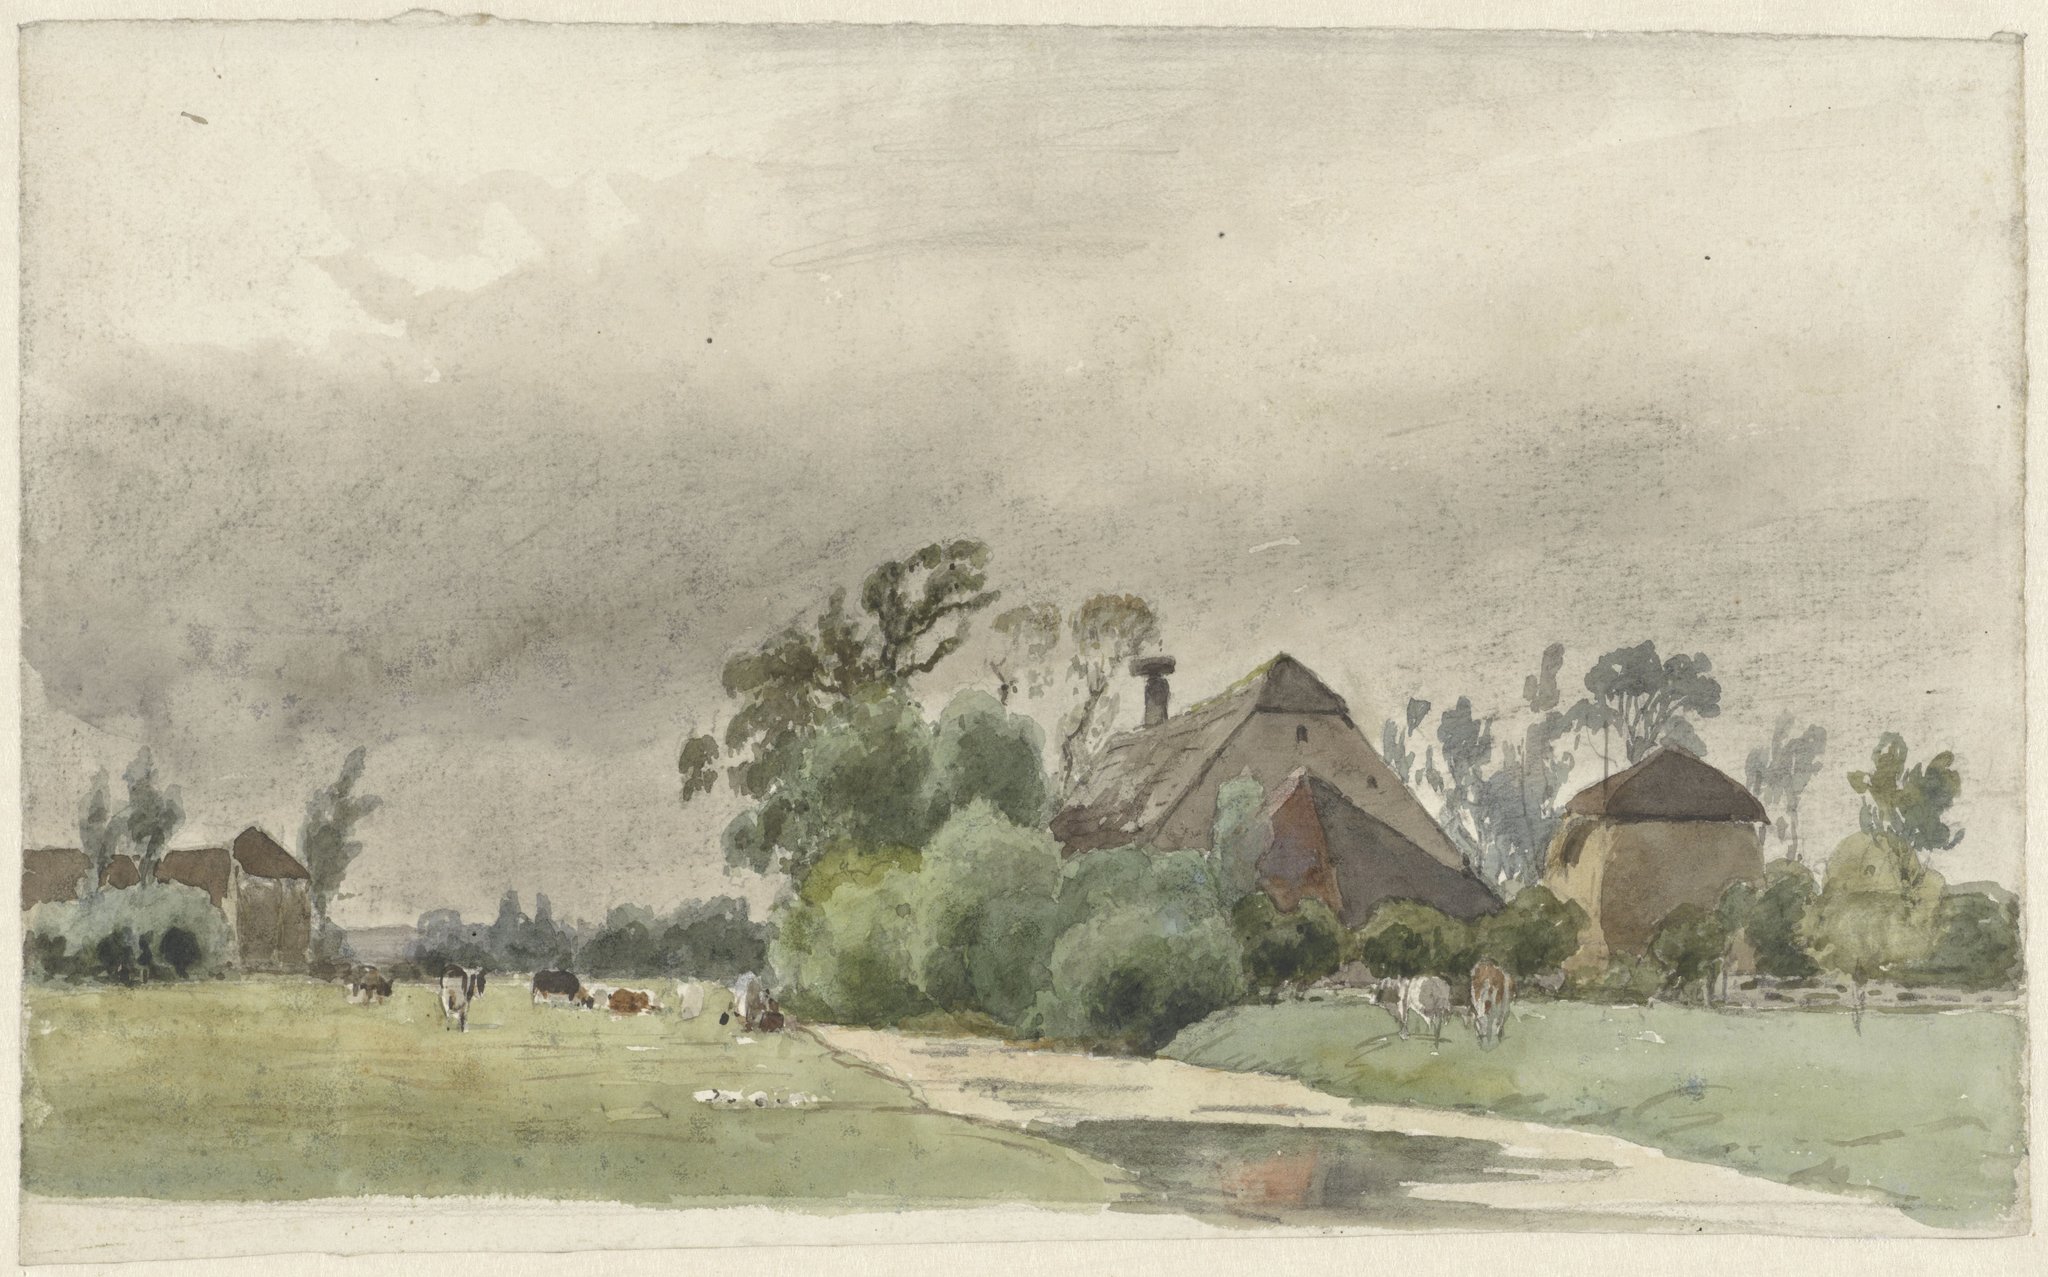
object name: drawing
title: Vaart leidend naar een boerderij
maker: julius jacobus van de sande bakhuyzen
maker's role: draughtsman, painter, print maker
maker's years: 1835-1925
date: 1845-1925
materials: chalk, paper, pencil, watercolor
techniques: brush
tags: farm or solitary house in landscape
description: Een vaart leidend naar een boerderij met vee in het weiland.